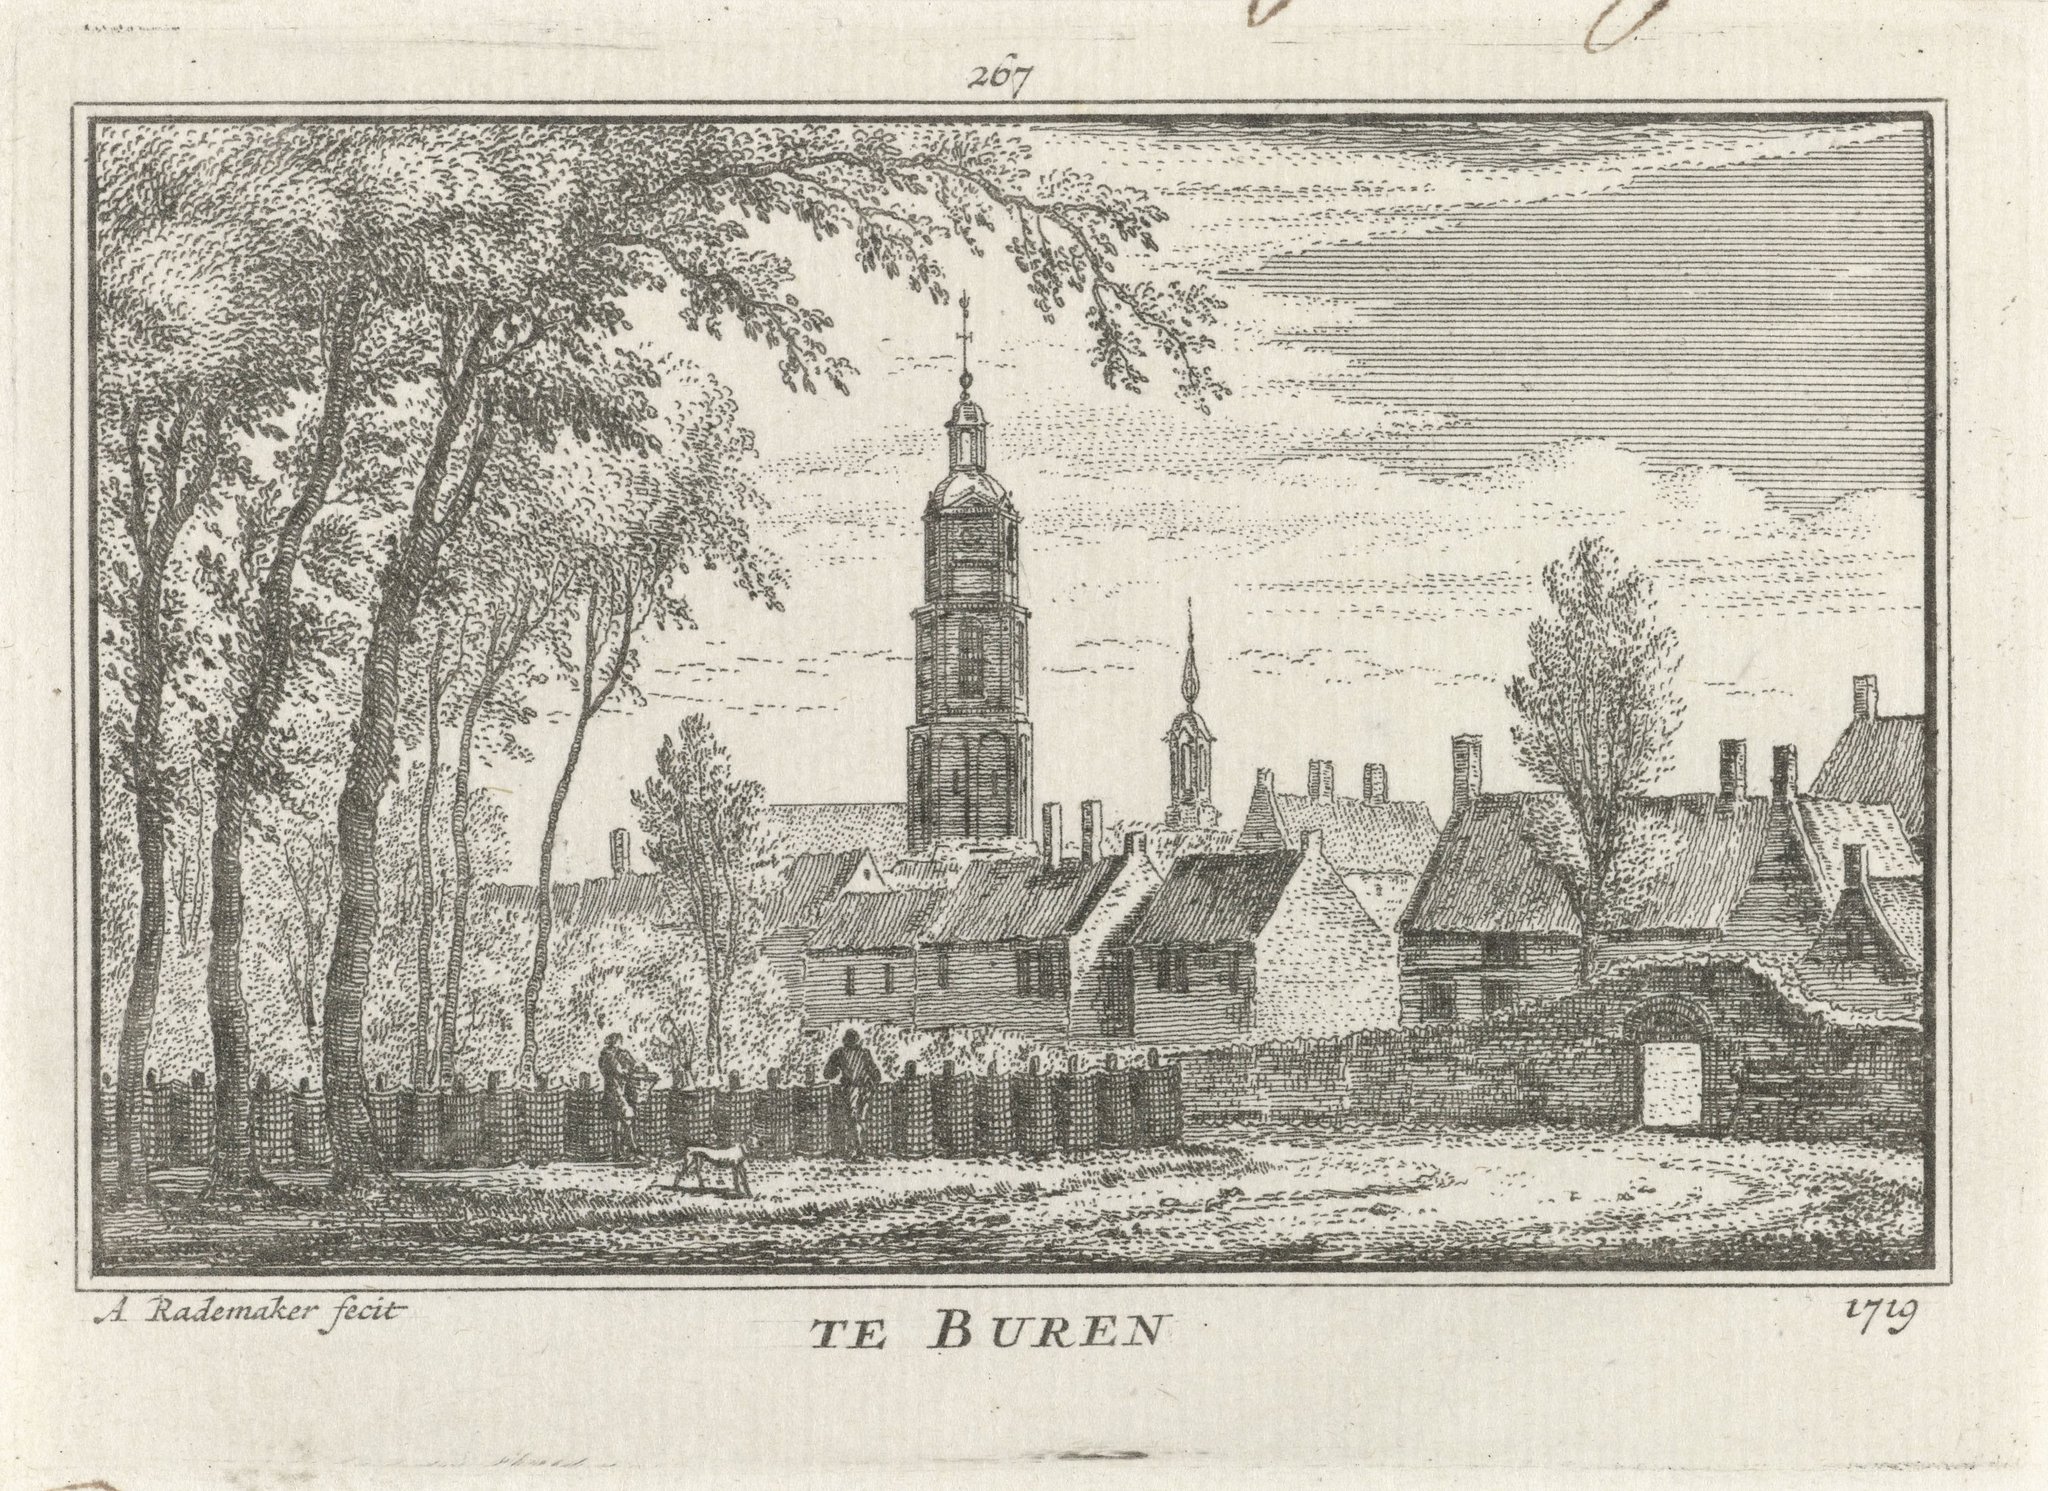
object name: book illustration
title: Te Buren 1719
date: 1727-1733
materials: paper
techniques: etching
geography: amsterdam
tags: church (exterior), buren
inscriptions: collector's mark: Lugt 2228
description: Illustratie uit: Abraham Rademaker, Matthaeus Brouërius van Niedek, Isaac Le Long, Kabinet van Nederlandsche en Kleefsche outheden en (...) voorname stads- en landgebouwen, Willem Barents en Antoni Schoonenburg: Amsterdam, 1727-1733, ill. nr. 266.